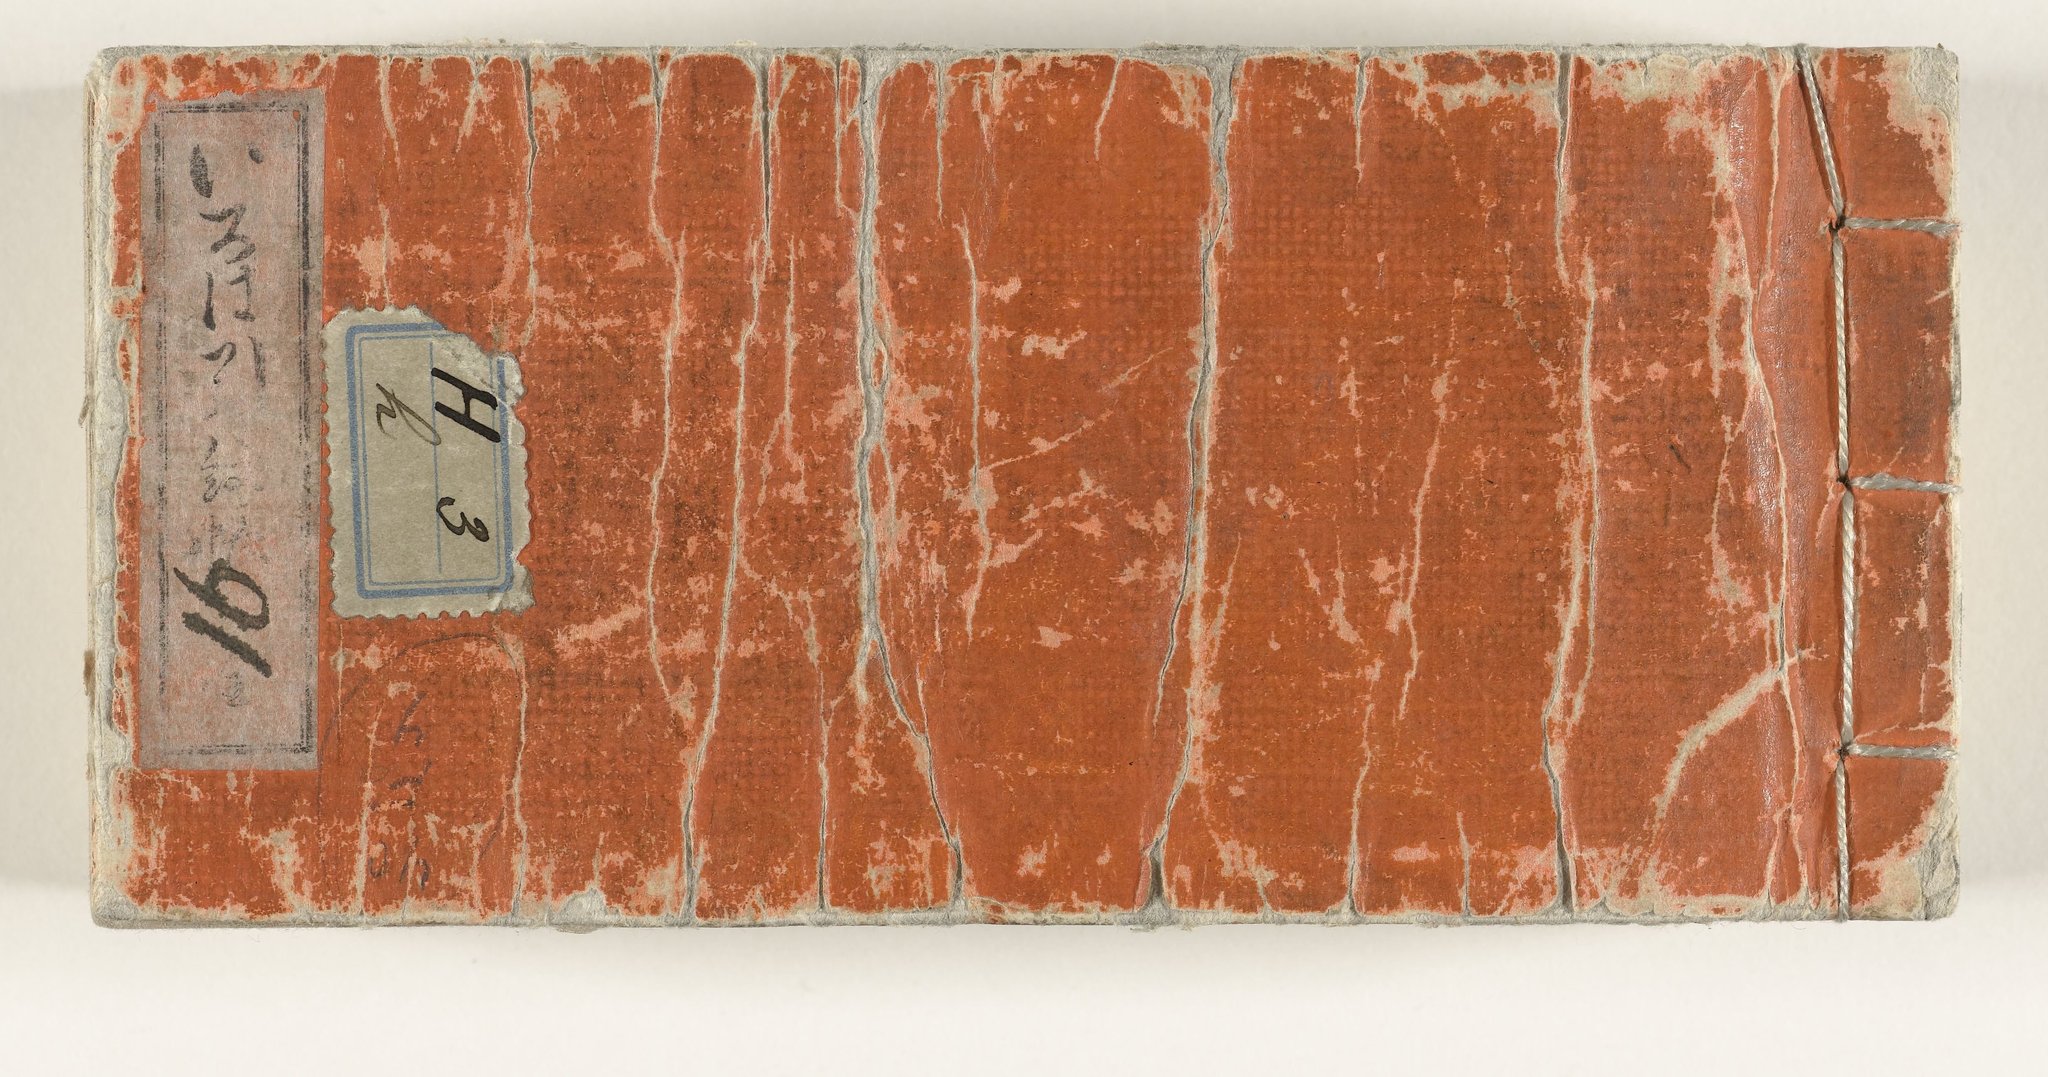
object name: book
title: Alfabetische gids van emblemen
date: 1881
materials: paper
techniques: woodcut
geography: tokyo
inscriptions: collector's mark: ‘Rijksschool voor kunstnijverheid’ Lugt 3937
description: Zie RP-P-OB-JAP-48 voor een tweede exemplaar van dezelfde gids.